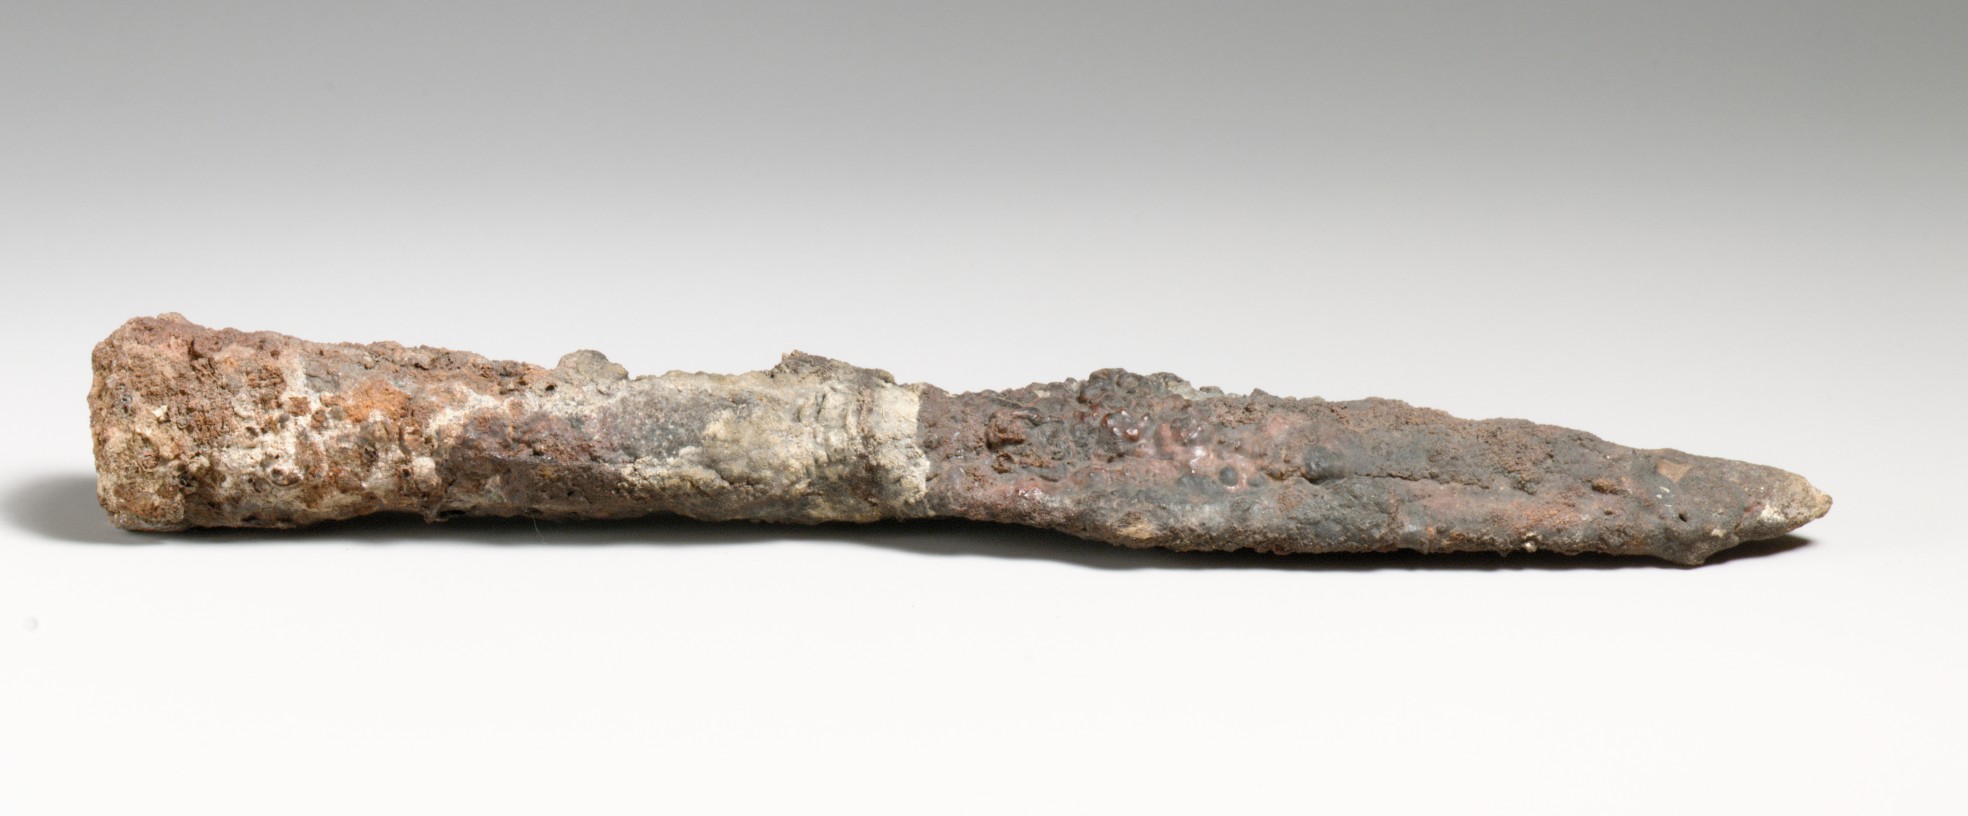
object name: spearhead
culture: cypriot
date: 1050-1000 BCE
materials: iron